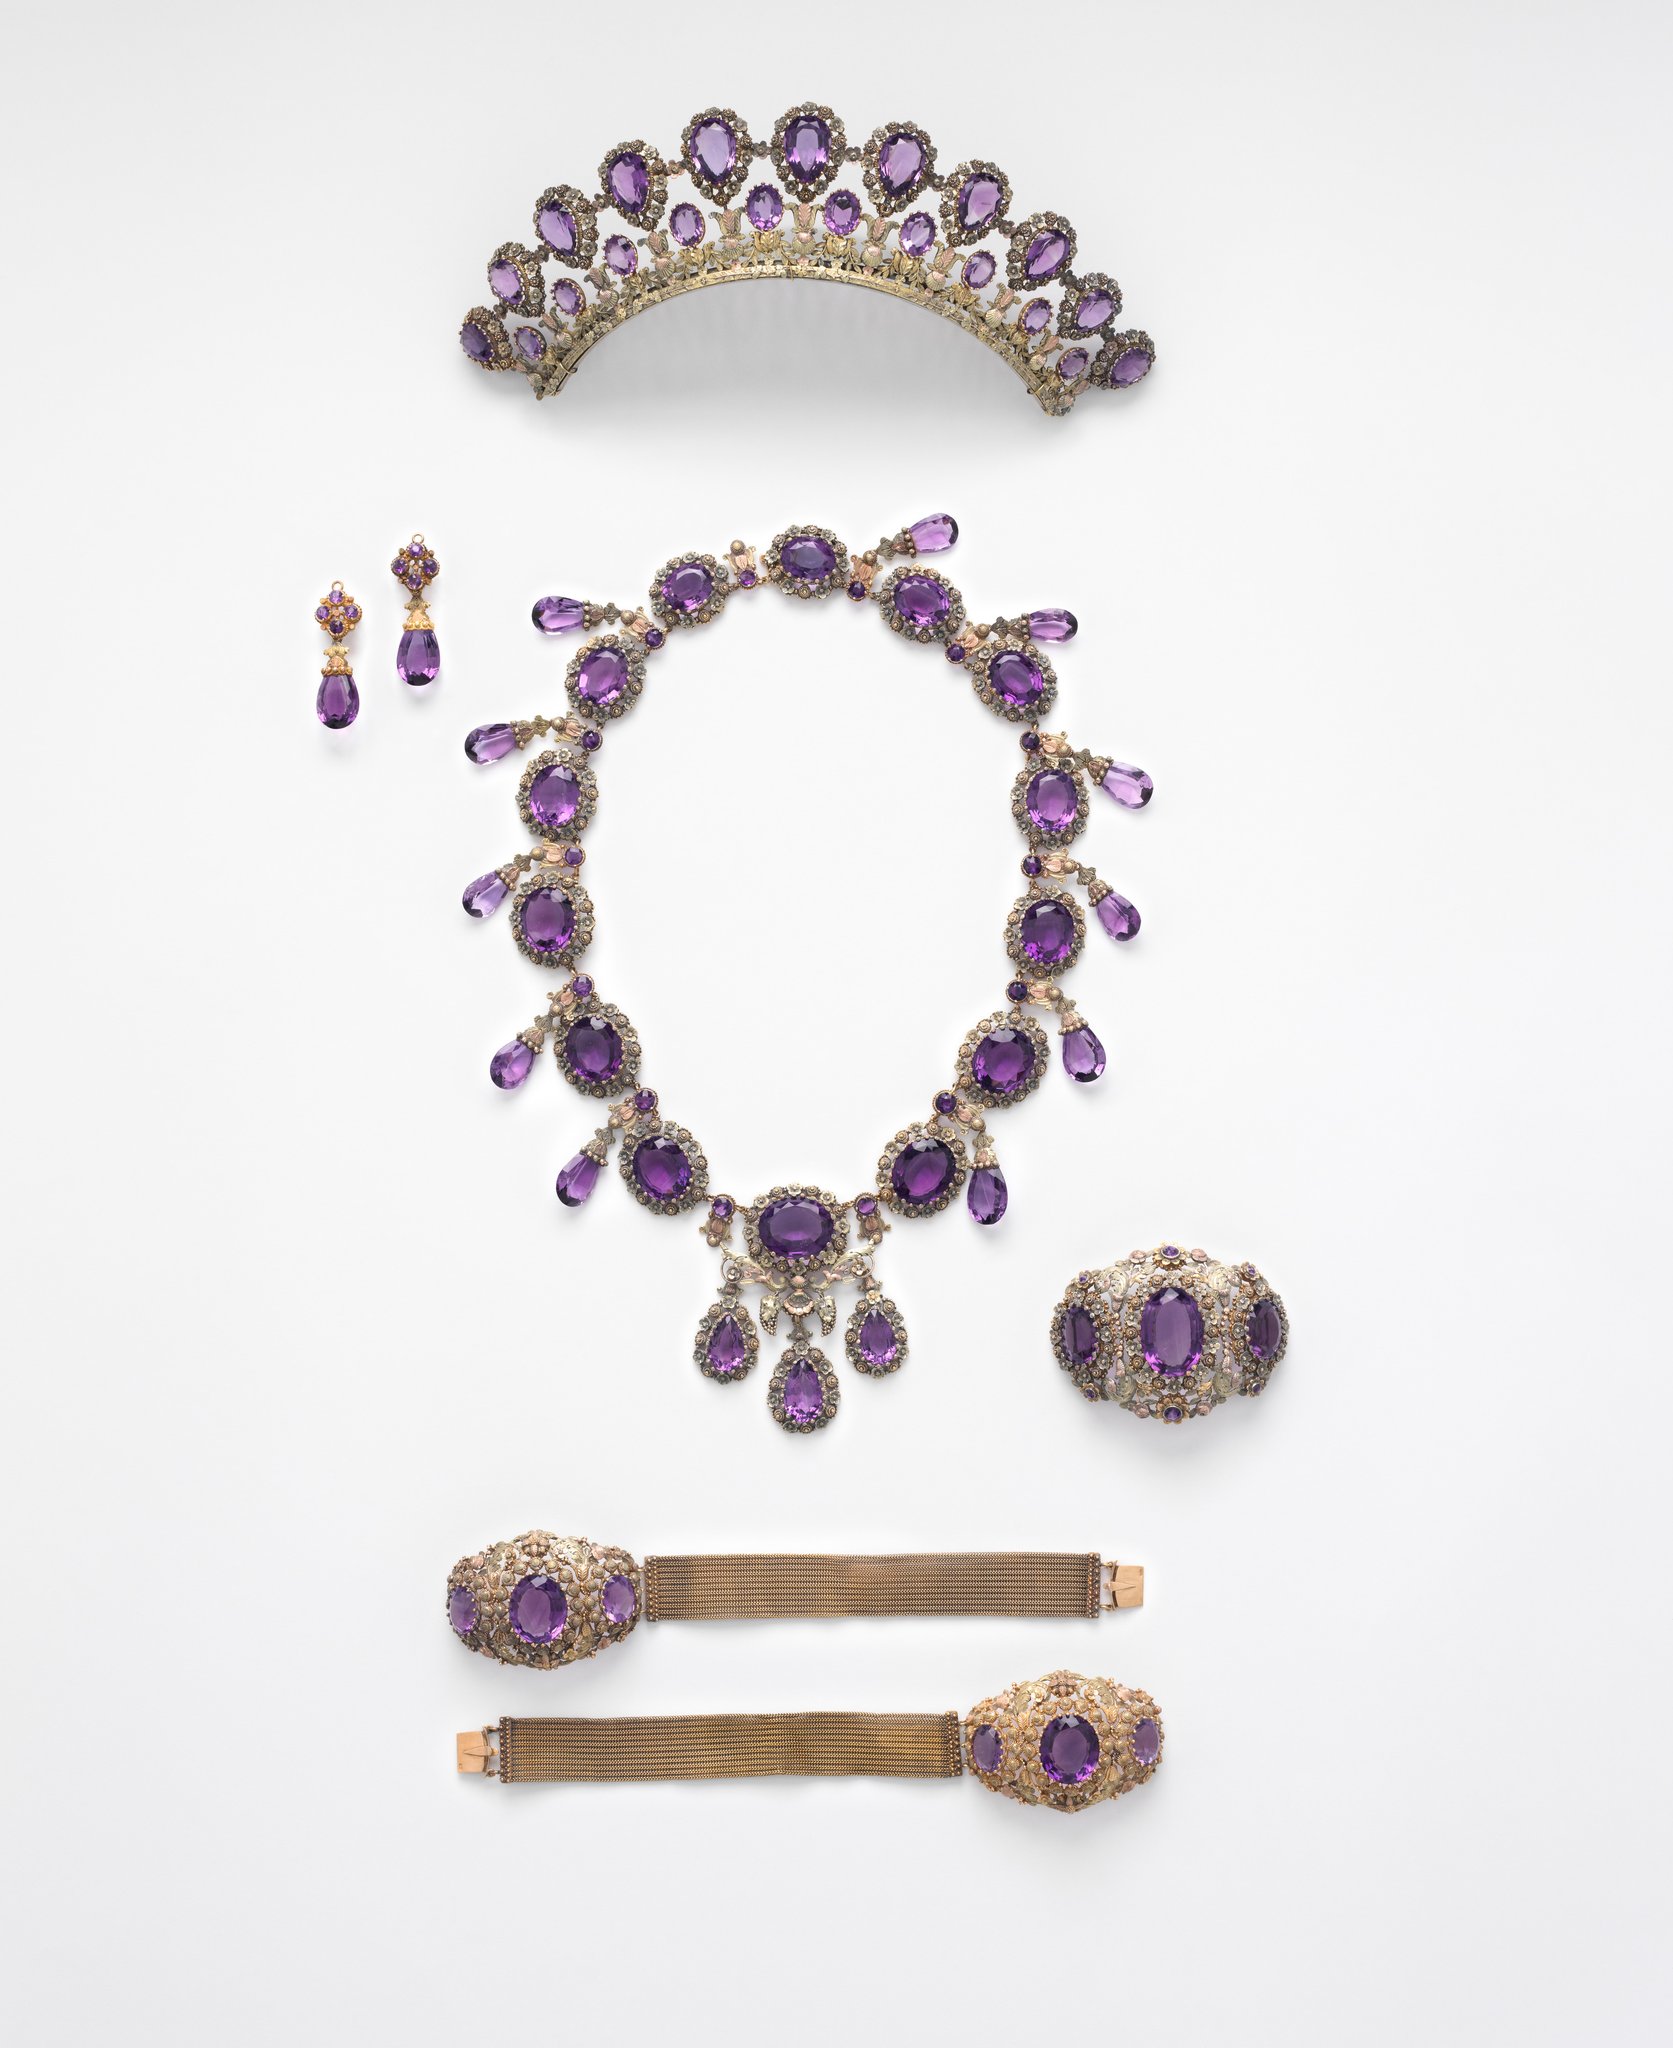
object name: bracelet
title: Bracelet (part of a set)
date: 1830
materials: amethyst, gold